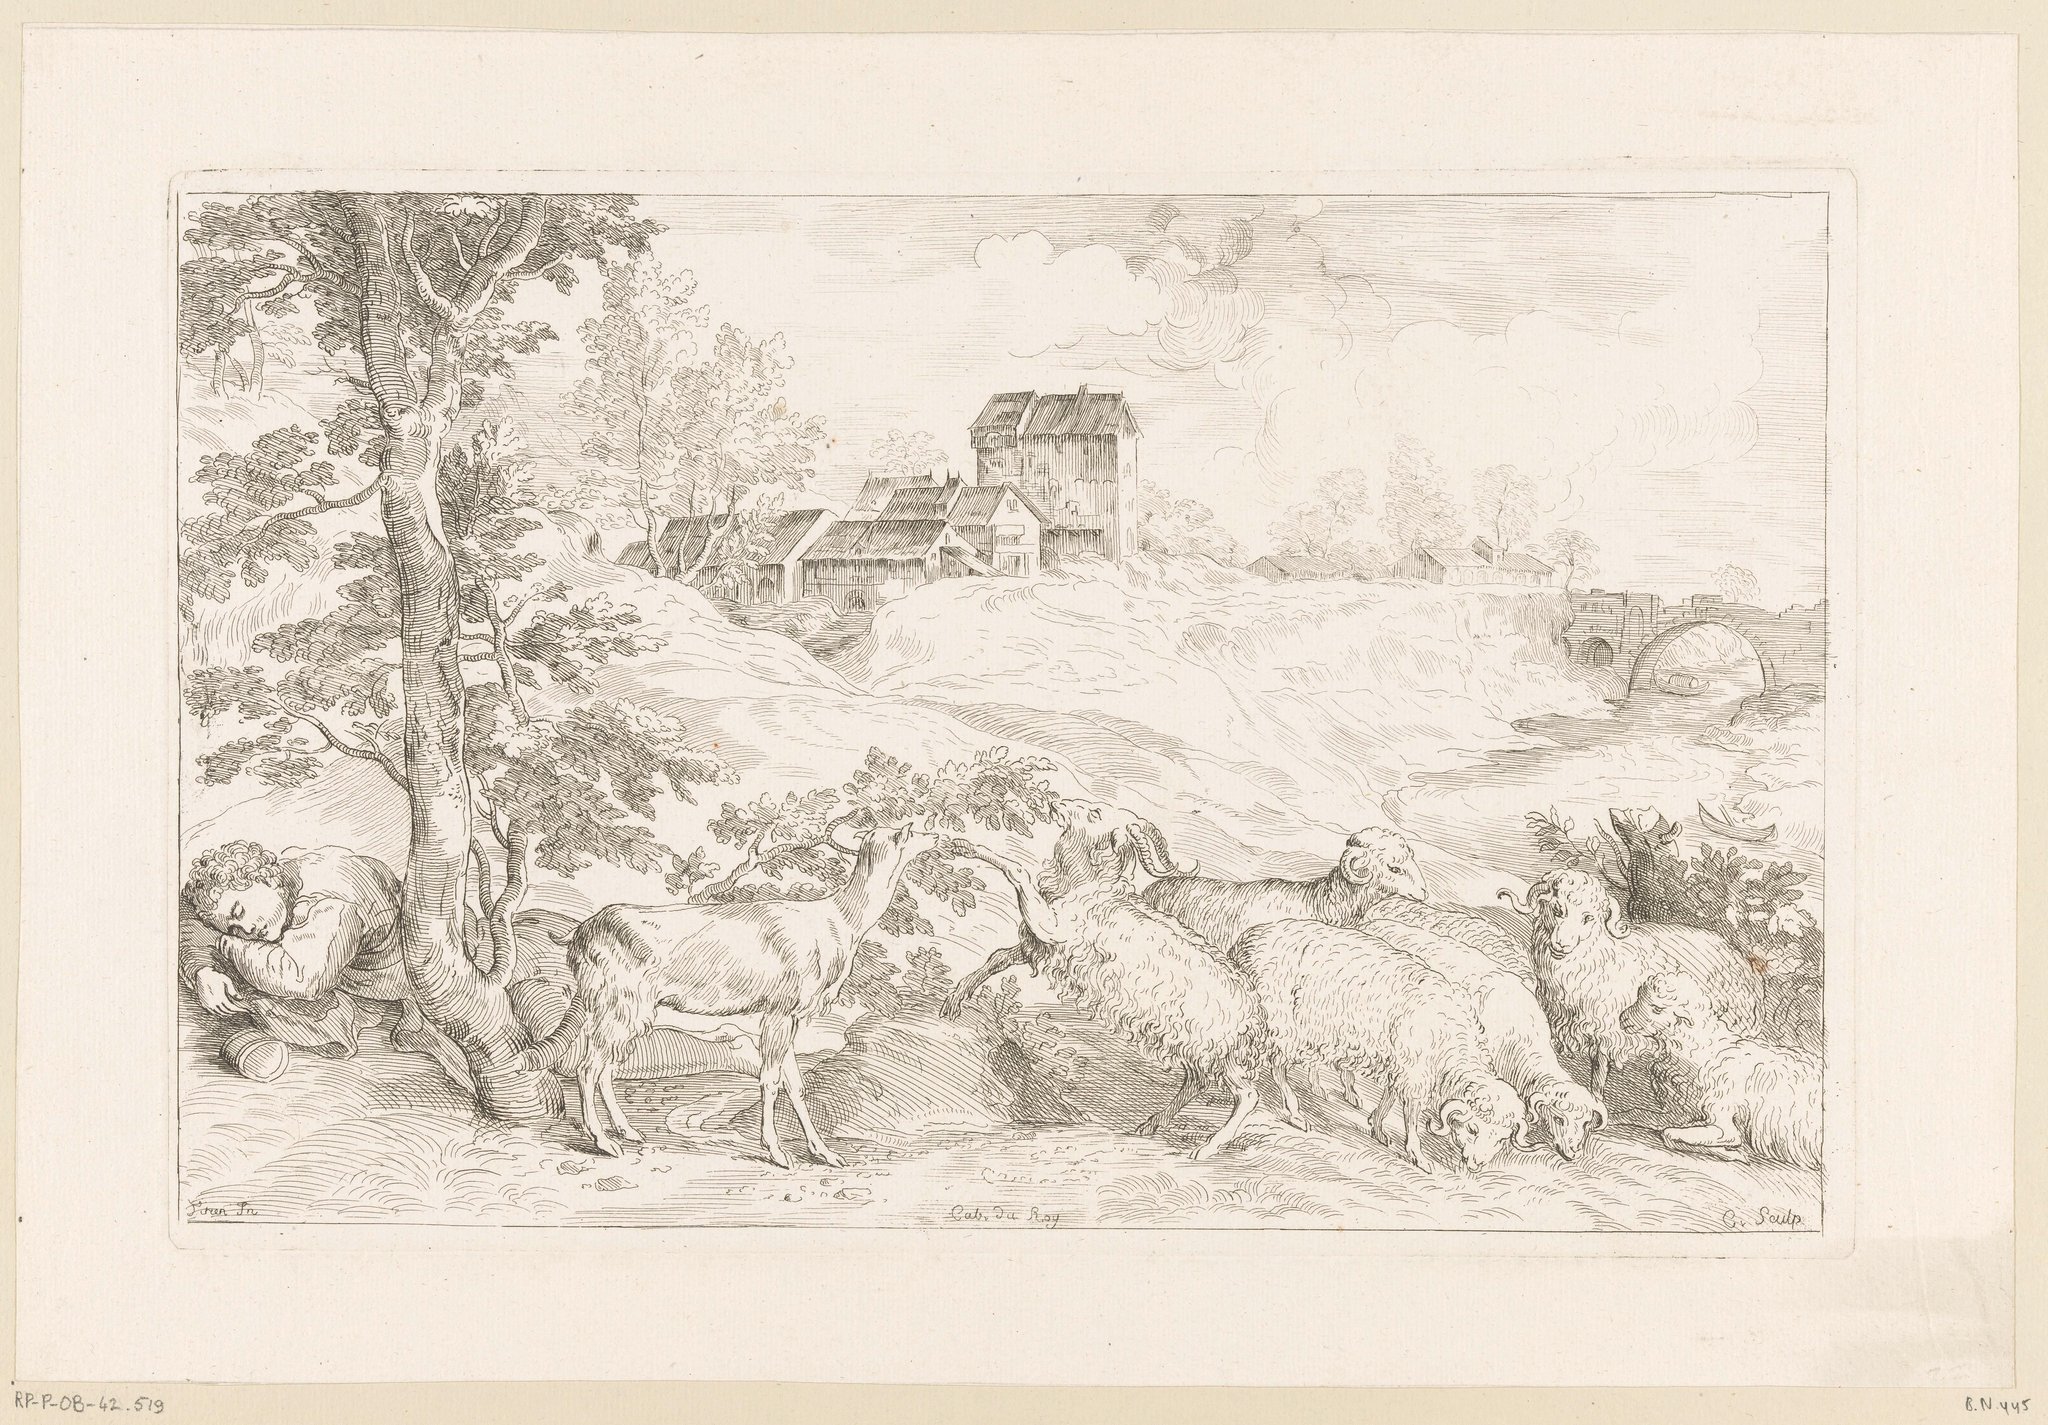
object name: print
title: Rivierlandschap met een slapende herder met zijn kudde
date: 1702-1765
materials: paper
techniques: etching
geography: france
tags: river bank - hh - ideal landscapes, herding, herdsman, herdswoman, shepherd, shepherdess, cowherd, etc., sleeping; unconsciousness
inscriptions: collector's mark: Lugt 240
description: Maakt deel uit van een serie getiteld: "Cabinet du Roy" van 222 etsen naar tekeningen uit de Franse koninklijke collectie.